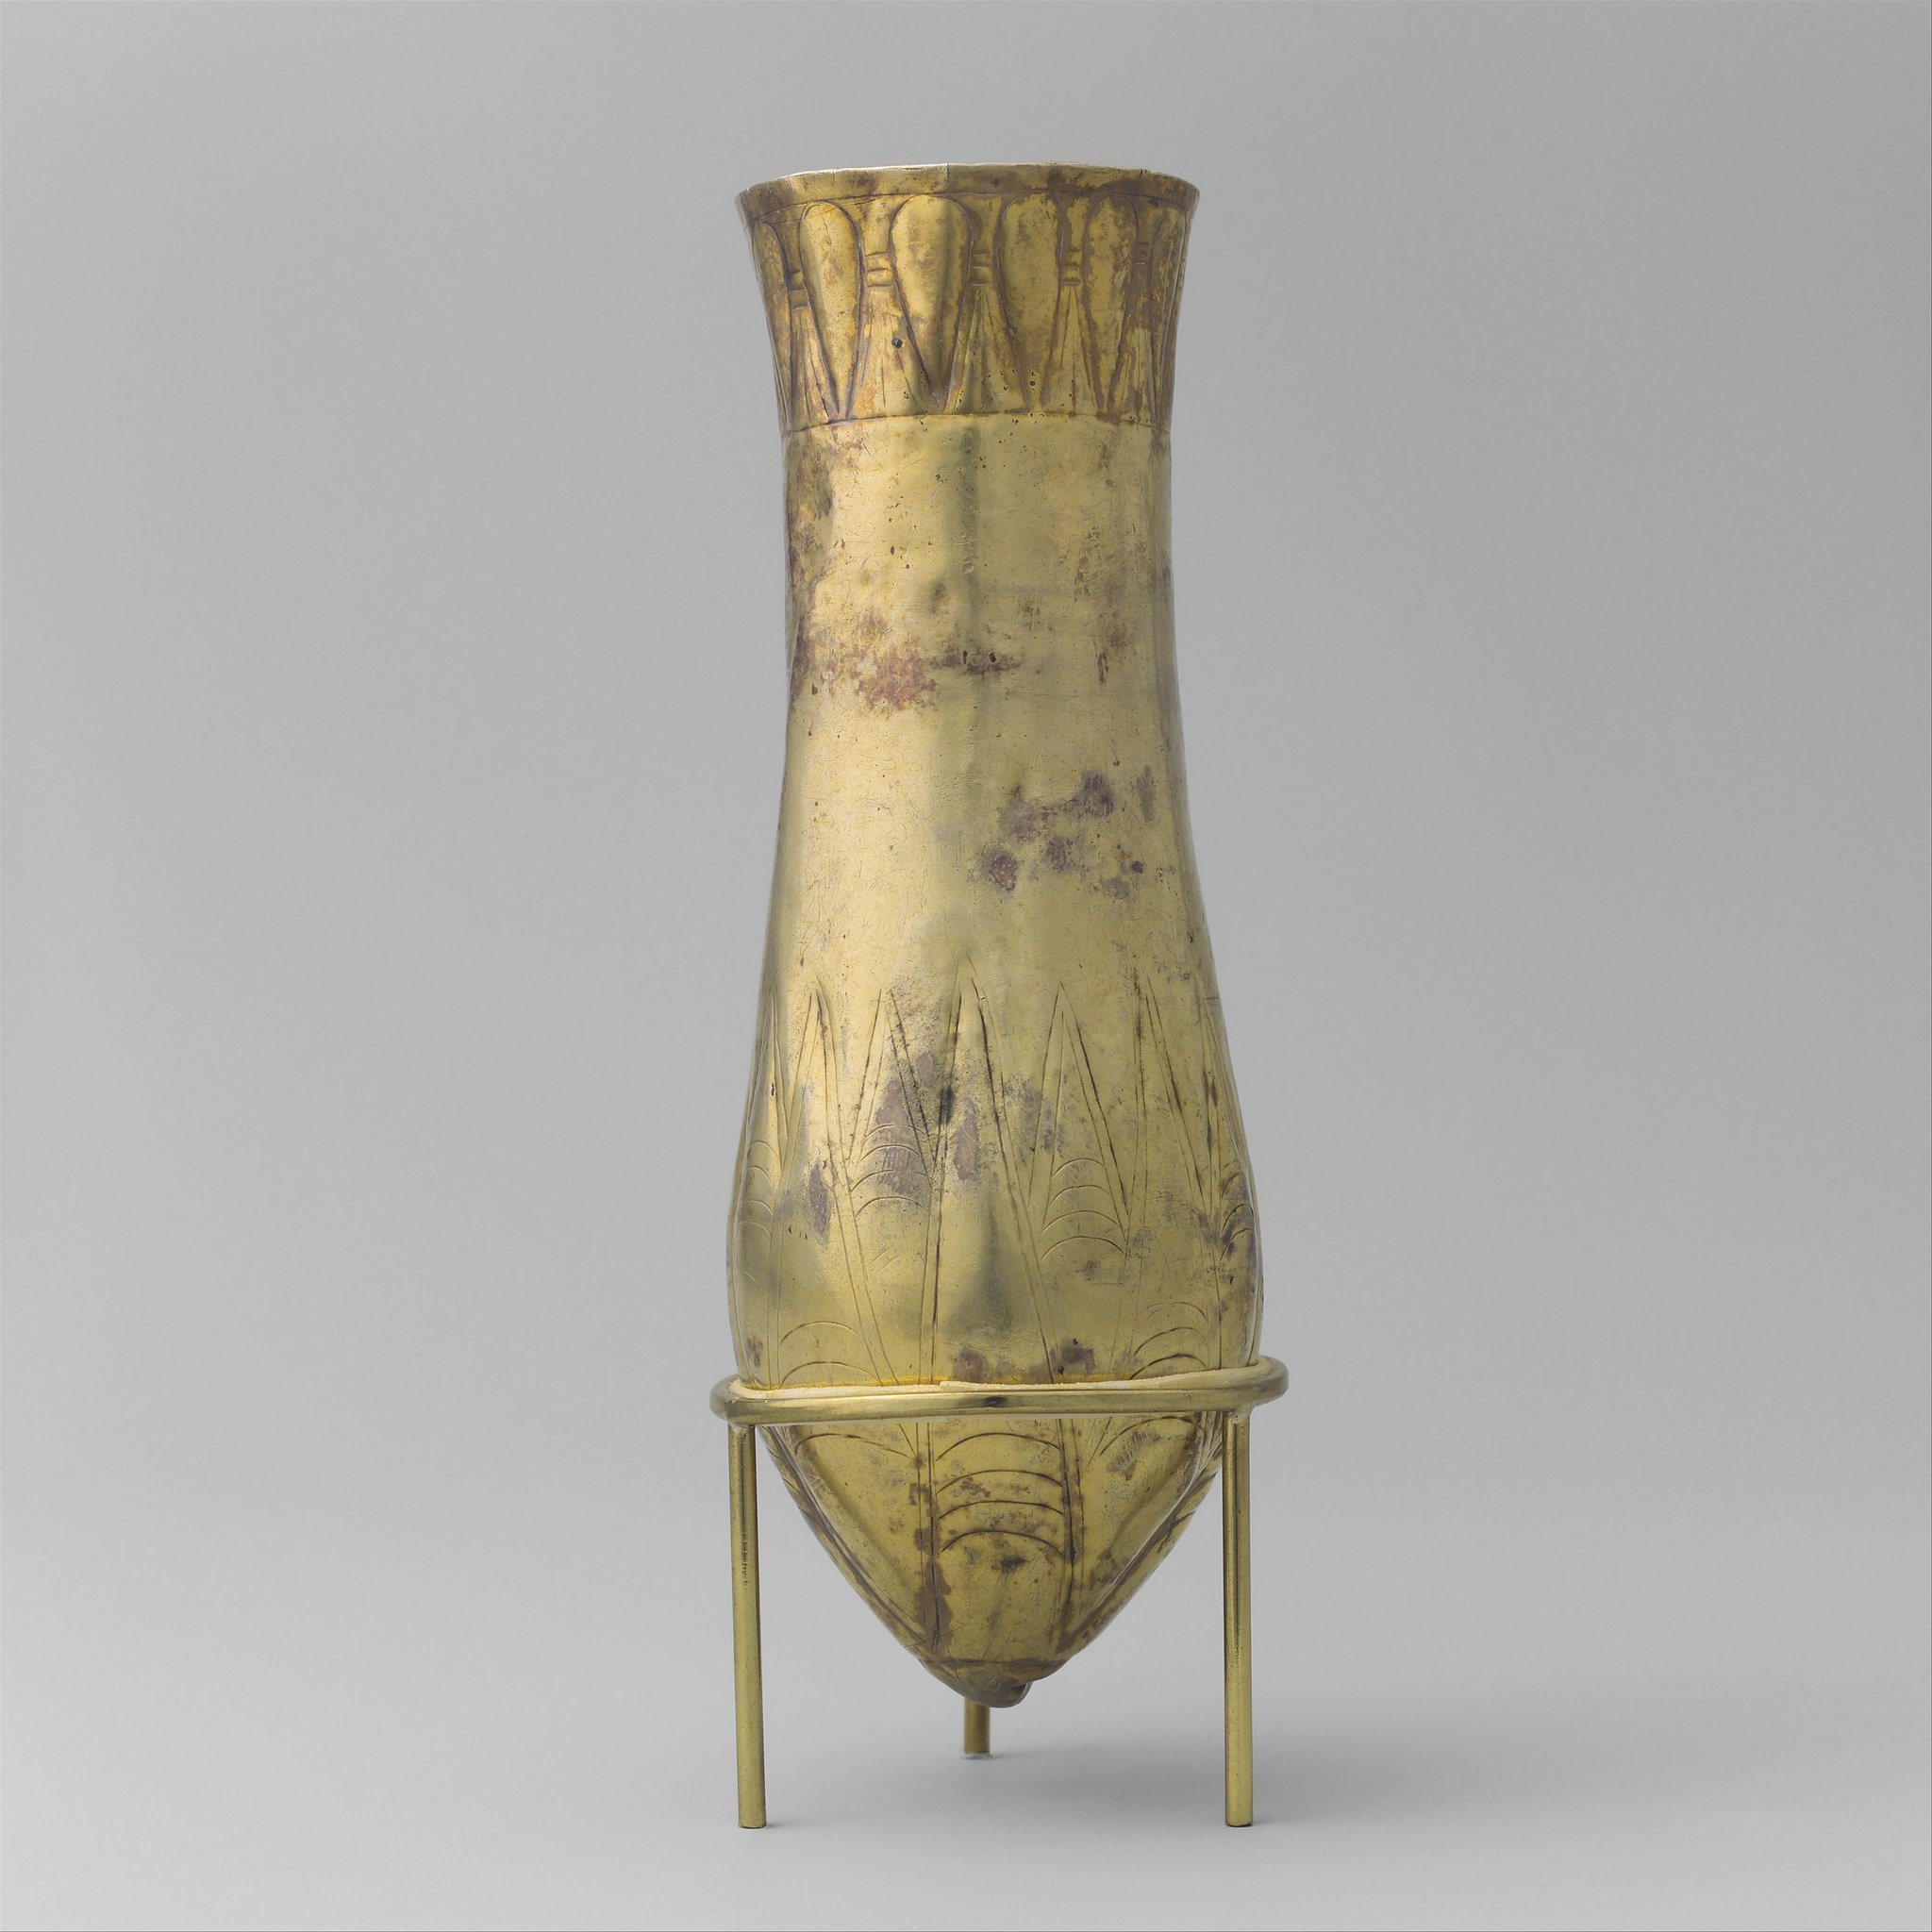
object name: situla, floral decoration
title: Situla with floral decoration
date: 1279-1213 BCE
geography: egypt